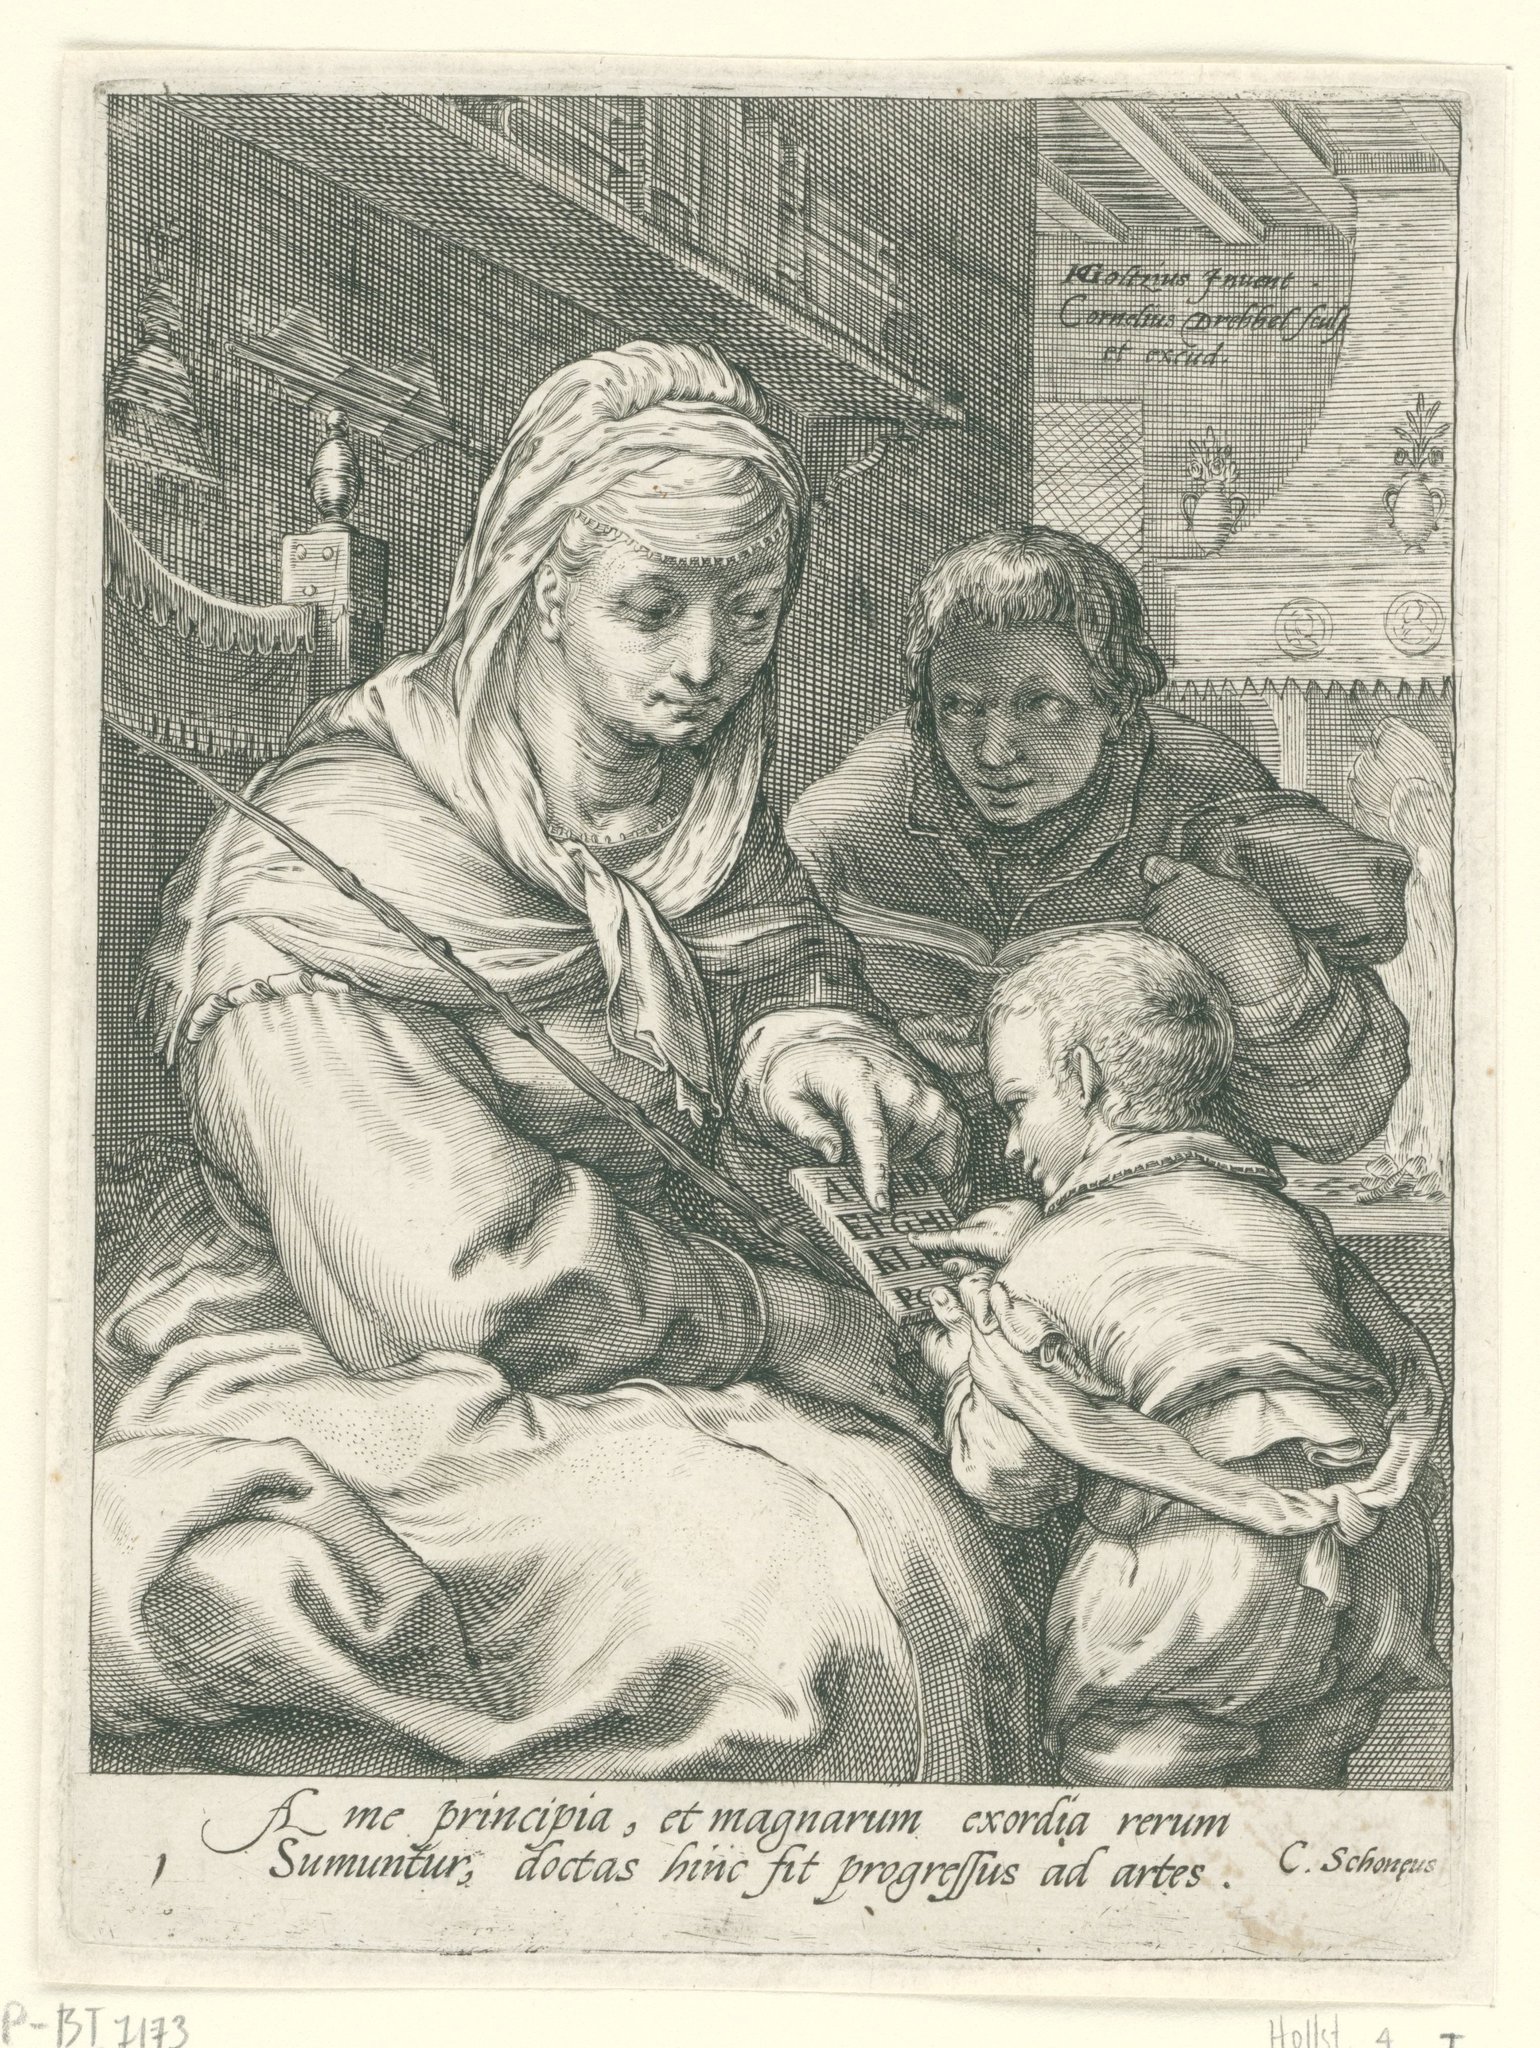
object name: print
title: Grammatica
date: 1587-1605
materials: paper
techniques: engraving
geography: haarlem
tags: 'grammatica' (~ trivium); 'grammatica' (ripa)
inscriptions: collector's mark: Lugt 240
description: Grammatica wijst een leerling de letters van het alfabet op een leesplankje aan. Een oudere jongen kijkt over haar schouder mee. Met een Latijns onderschrift door C. Schonaeus.